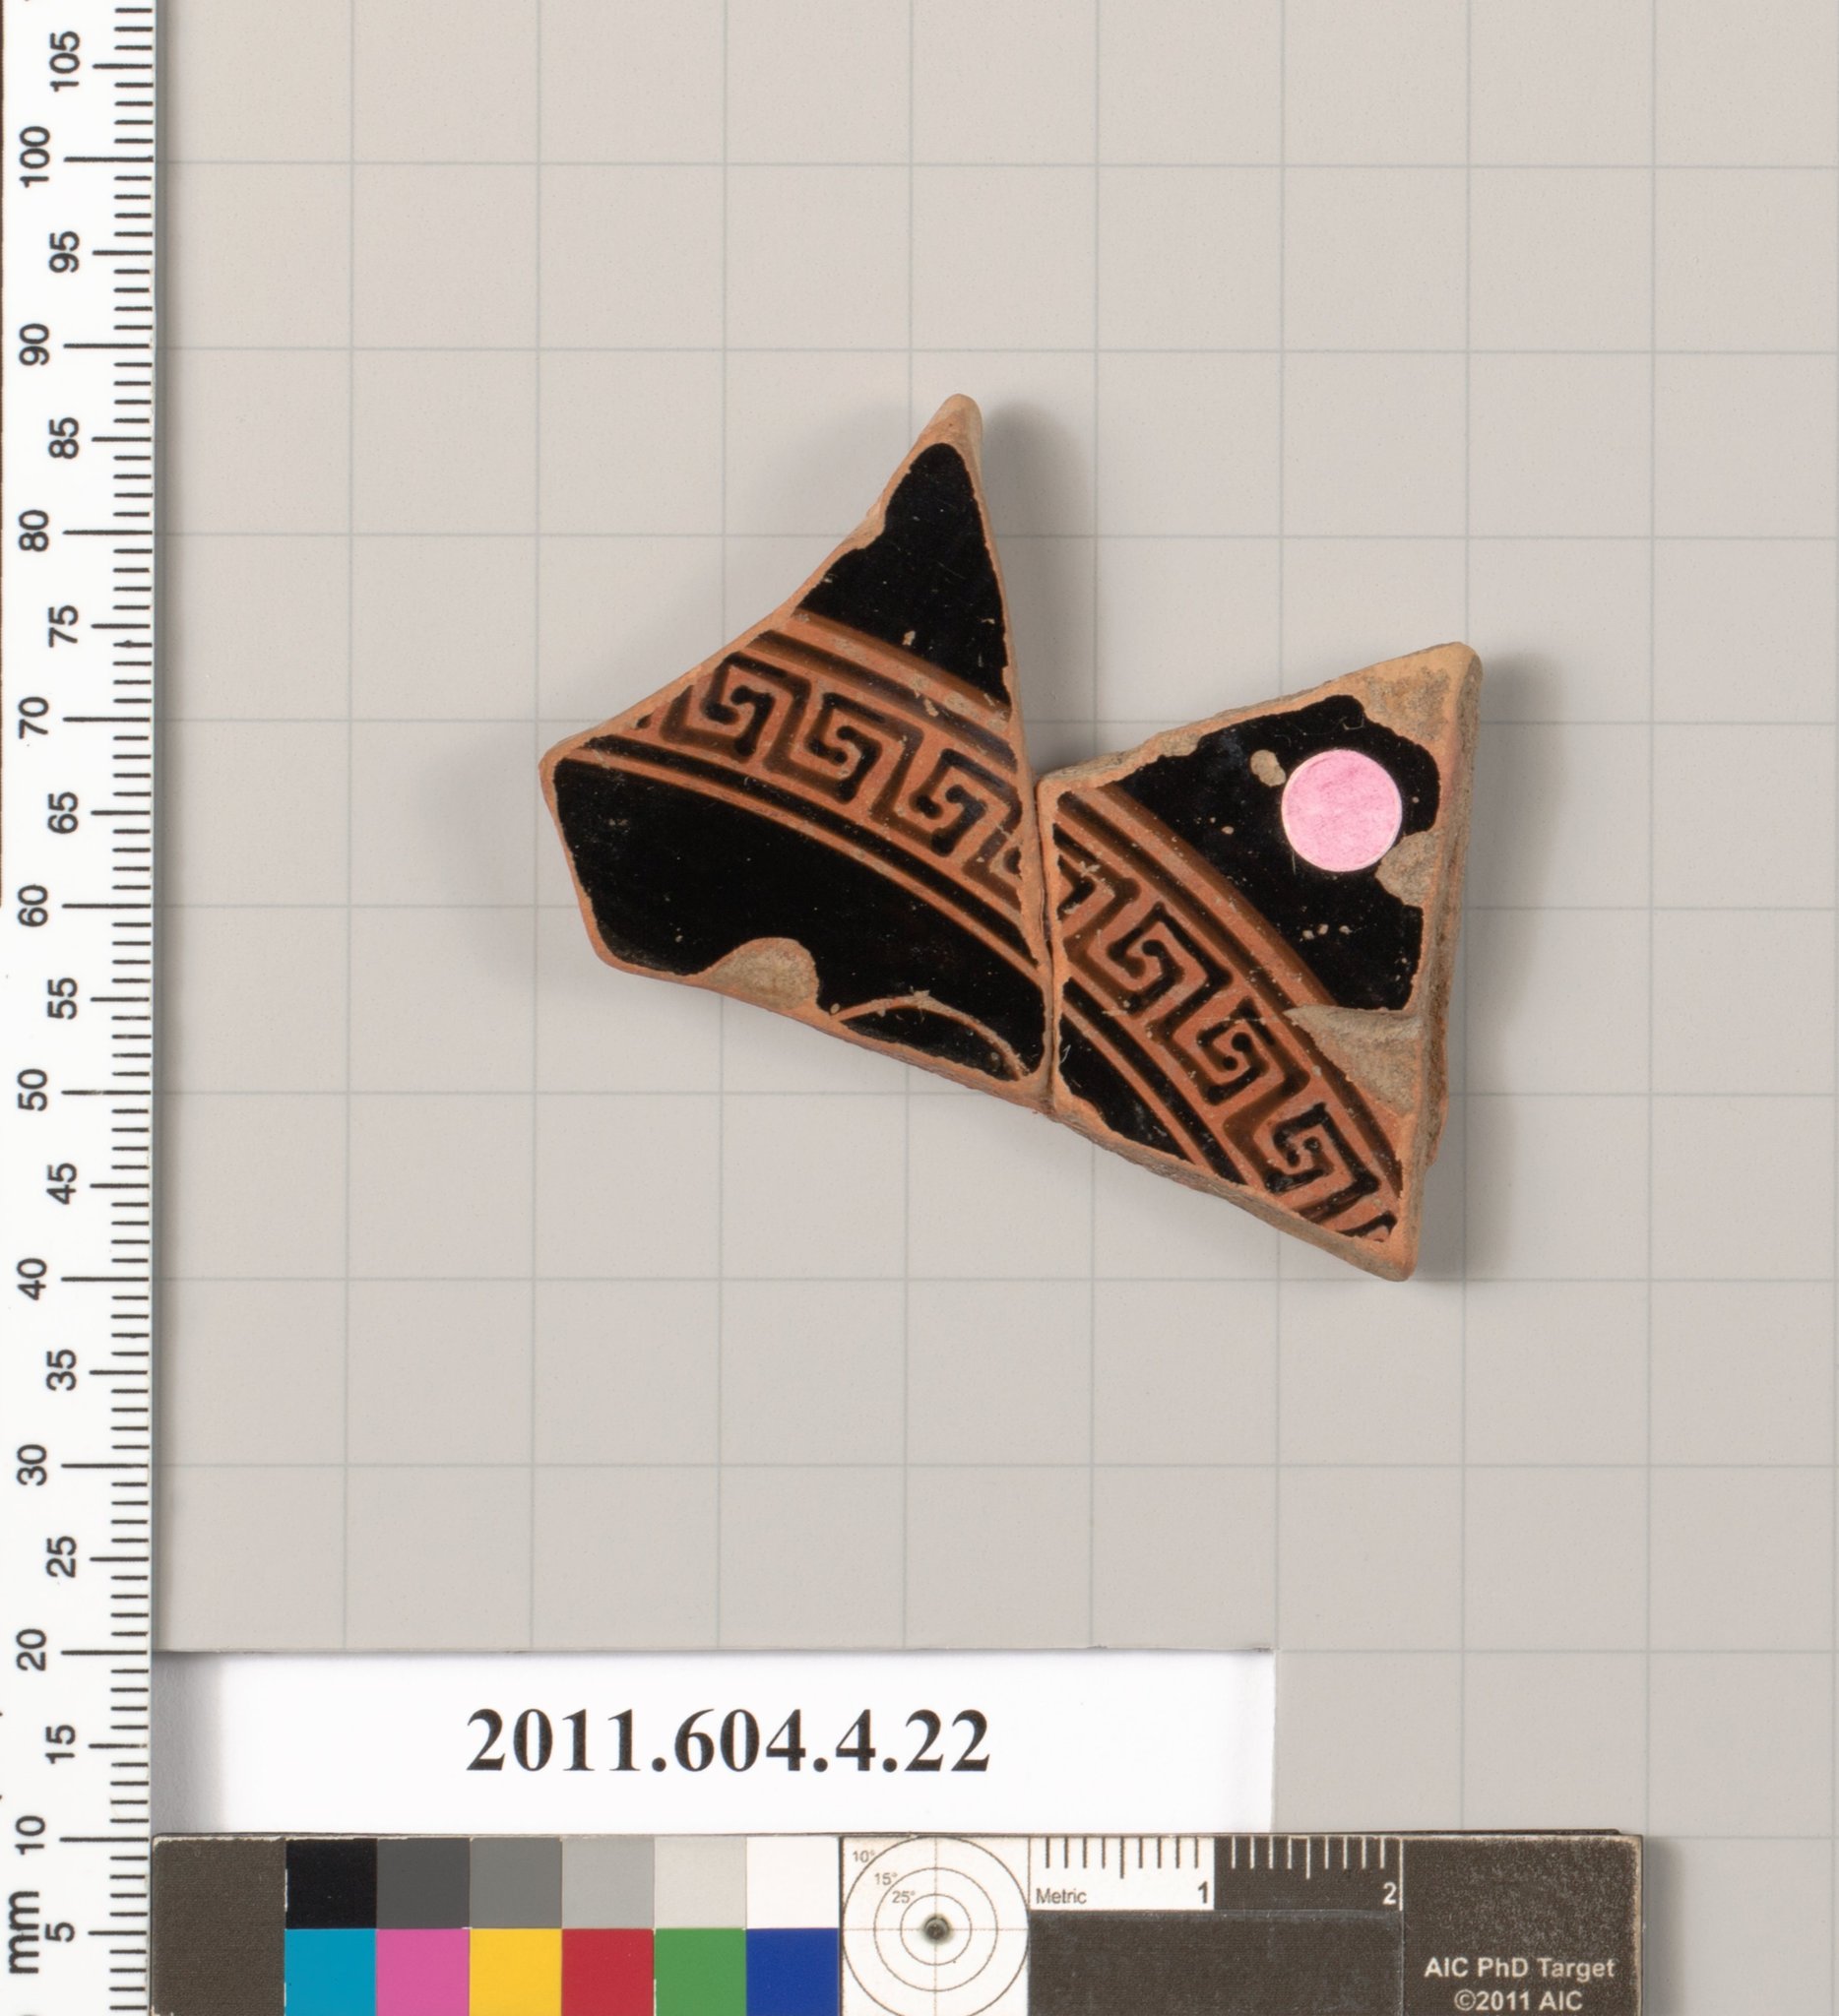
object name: kylix fragment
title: Terracotta fragment of a kylix (drinking cup)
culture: greek, attic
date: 490-480 BCE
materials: terracotta